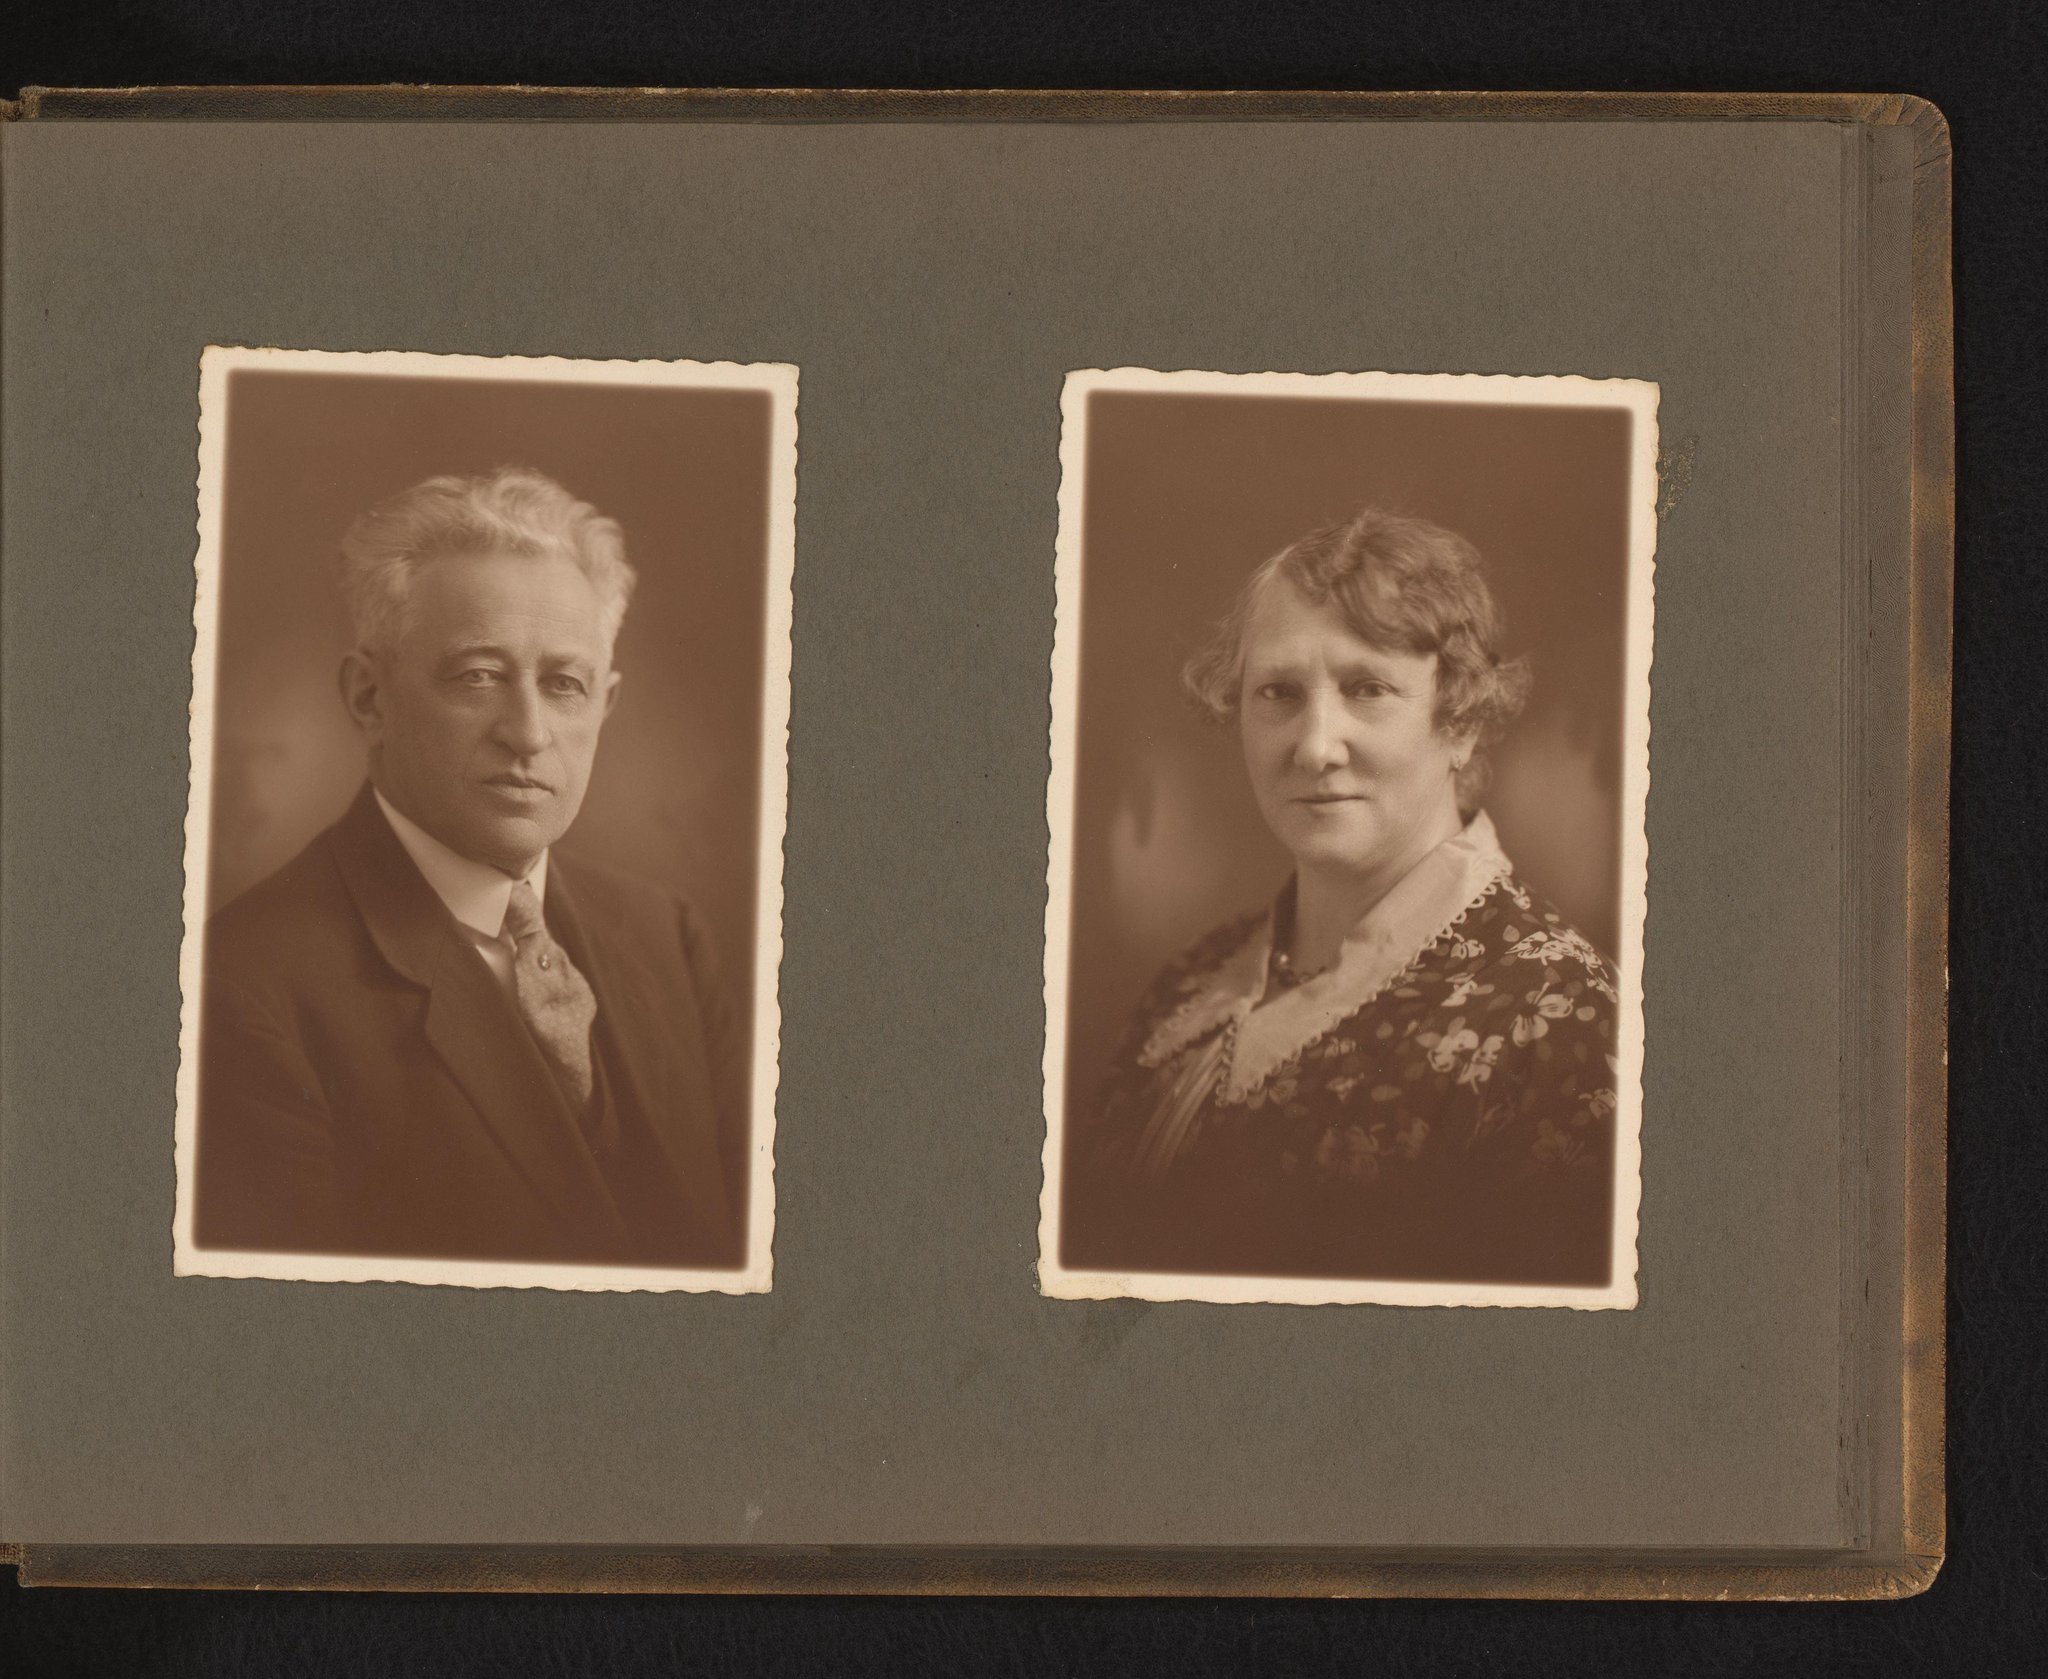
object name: album leaf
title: Portretten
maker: Anonymous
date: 1900-1950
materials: photographic support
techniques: gelatin silver print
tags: adult man, historical persons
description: Portret van een man en portret van een vrouw. Deze pagina maakt deel uit van een album.